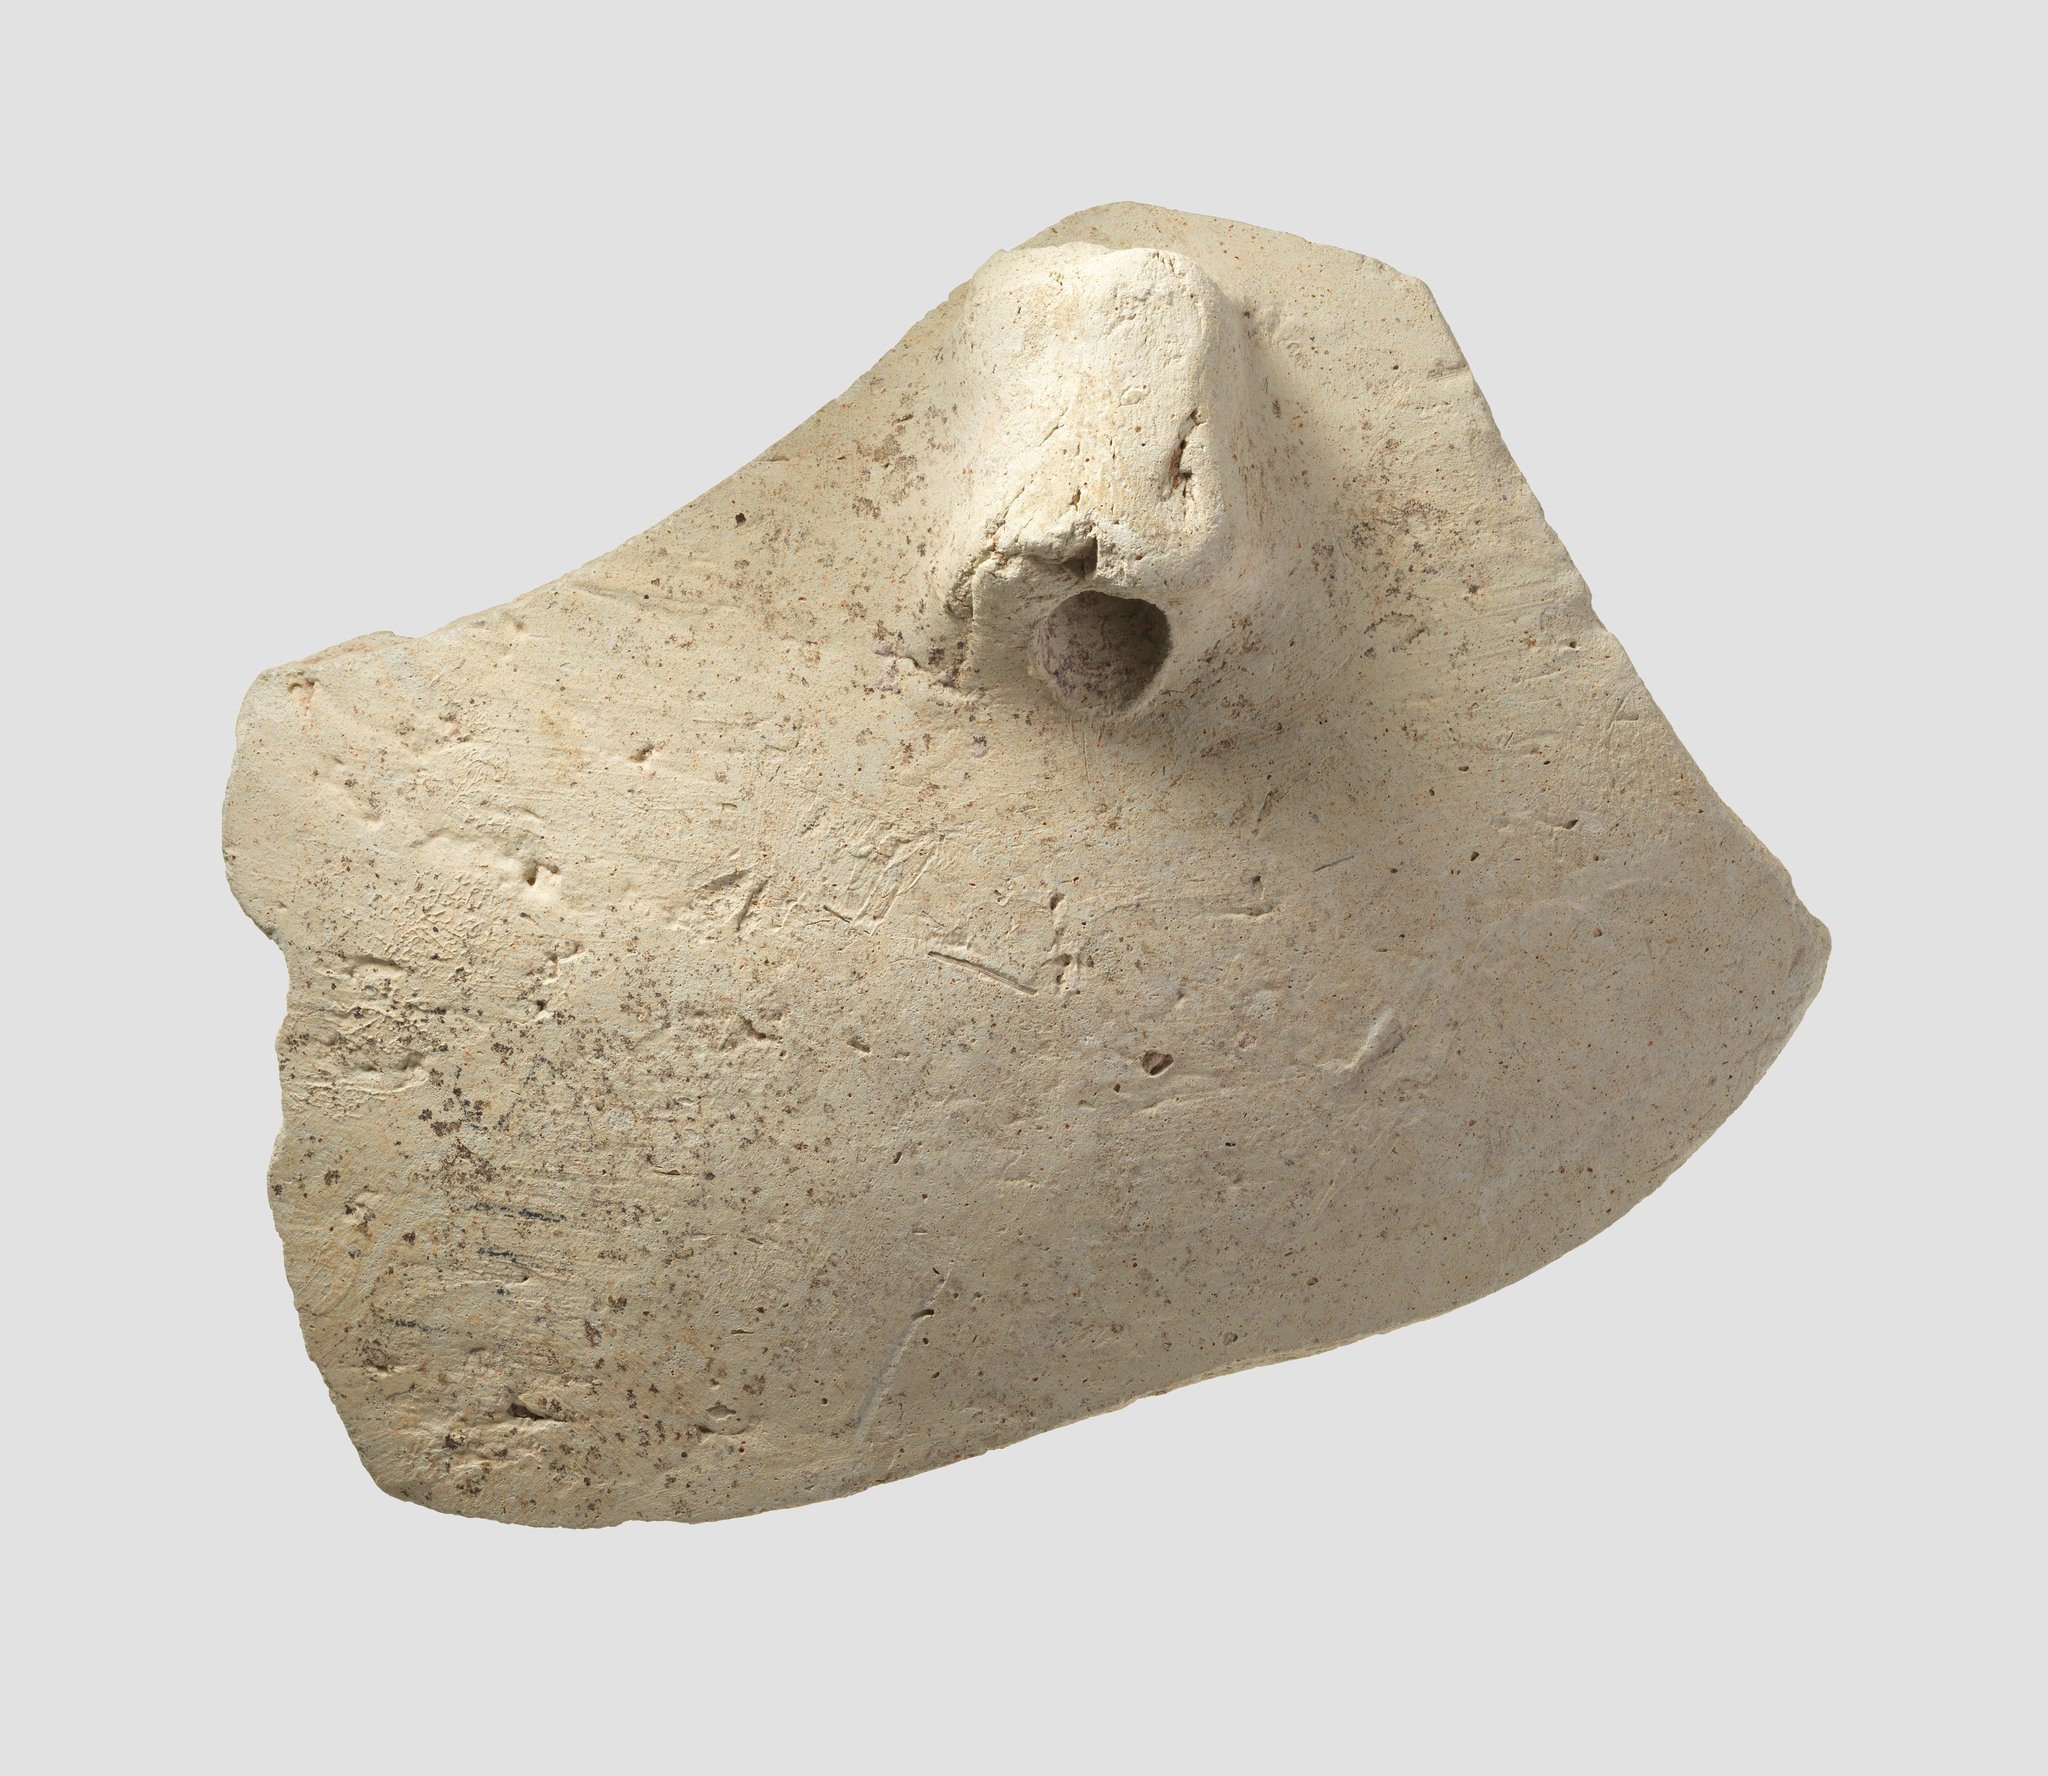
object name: sherd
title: Sherd with lug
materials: ceramic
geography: mesopotamia